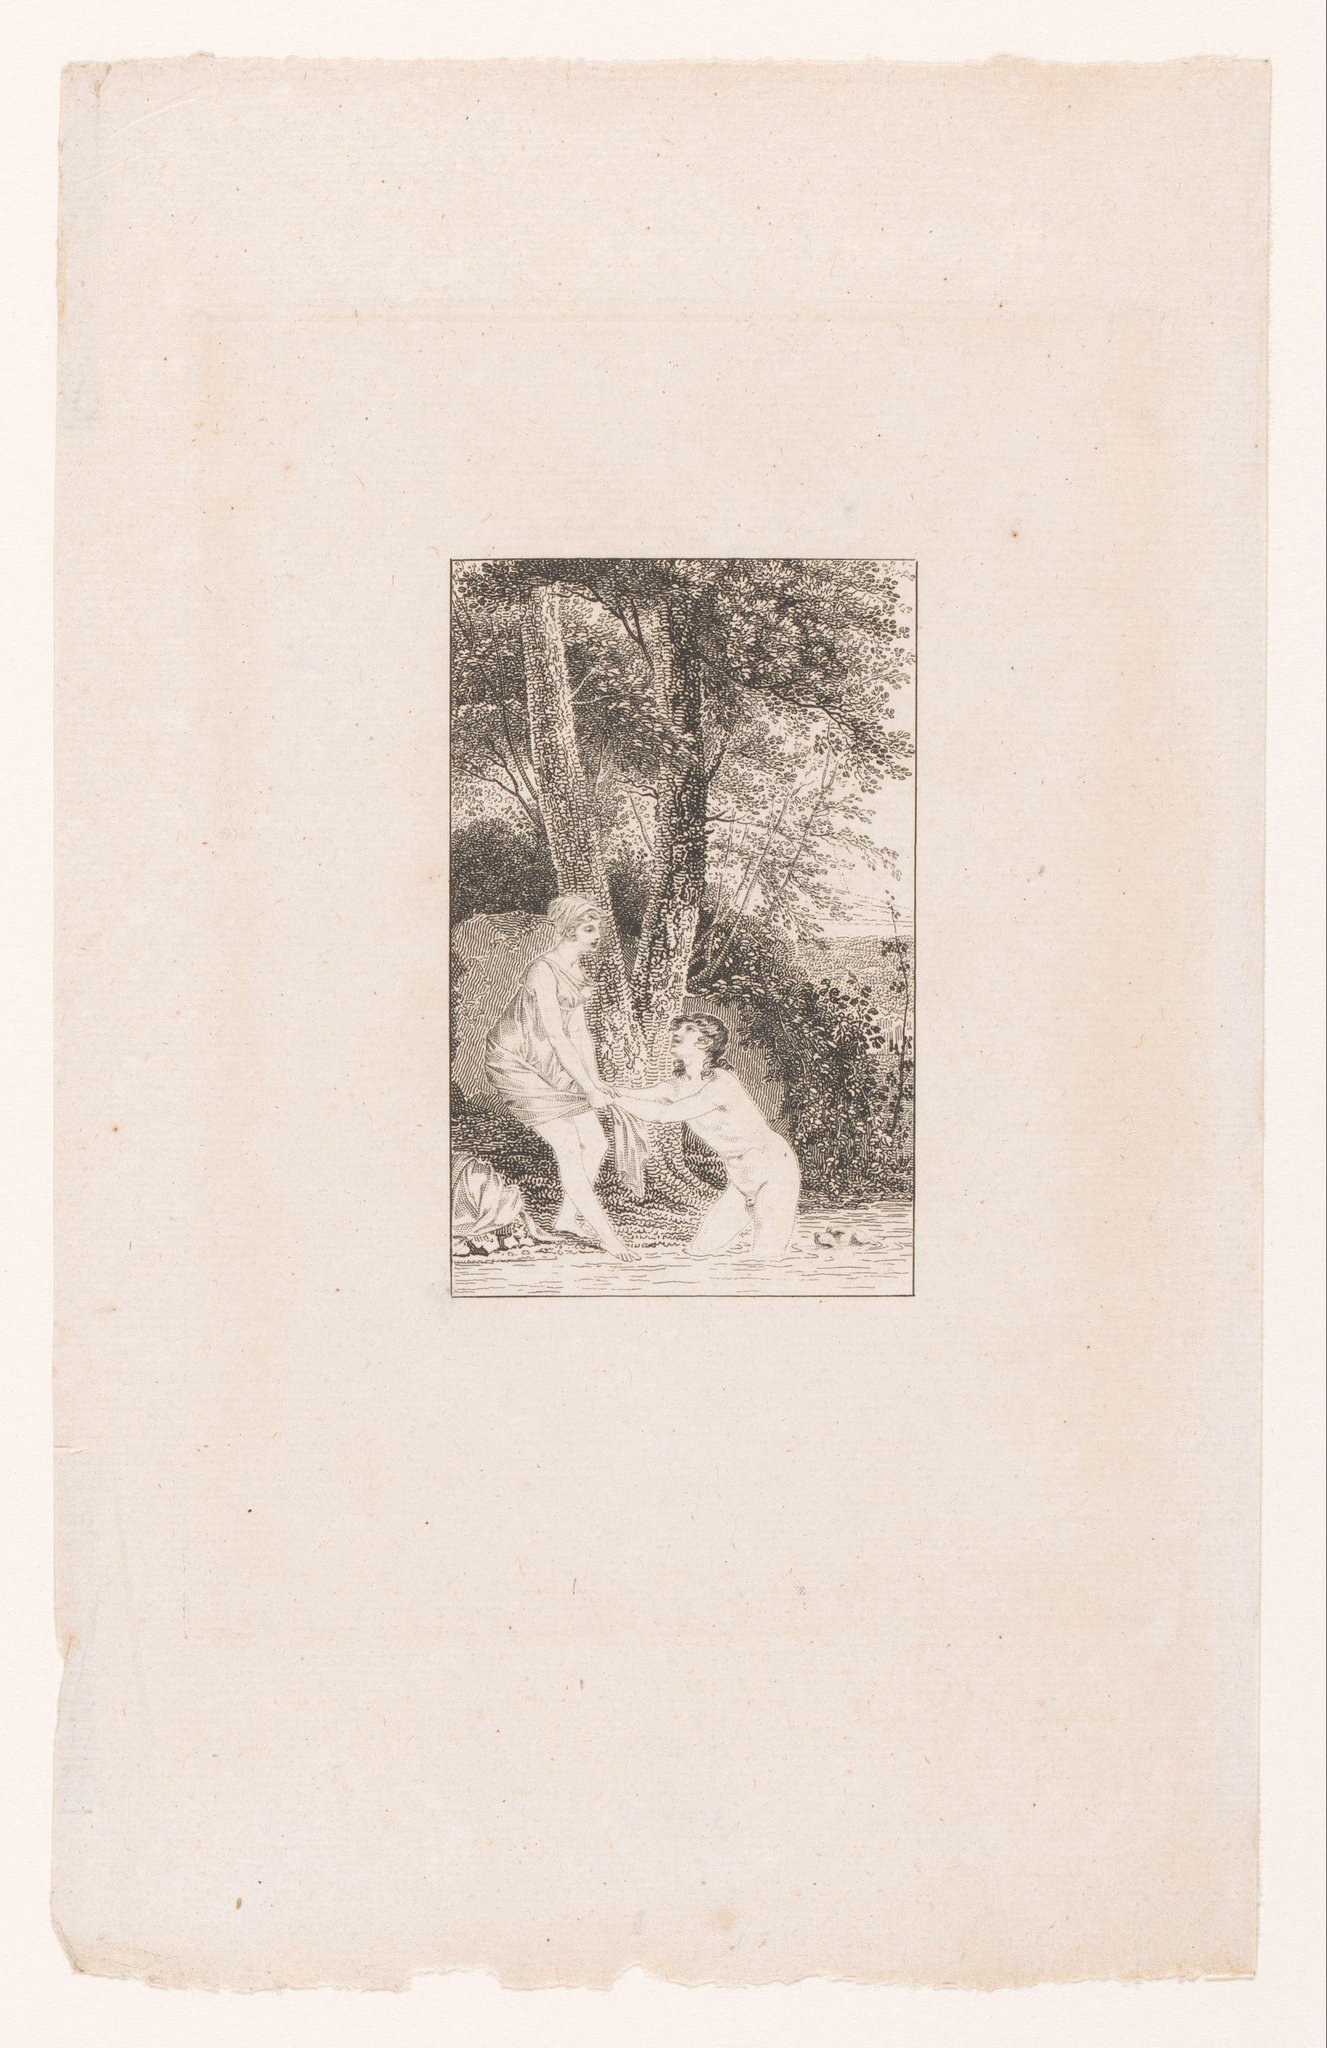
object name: print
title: Daphnis en Chloë badend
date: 1800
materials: paper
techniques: etching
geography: paris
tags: daphnis (in greek mythology a shepherd who invented pastoral poetry, chloe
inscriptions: collector's mark: Lugt 2228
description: Prent uit: Sofista, Longus. Gli amori pastorali di Dafni e Cloe. Parijs: Antoine Augustin Renouard, 1800.